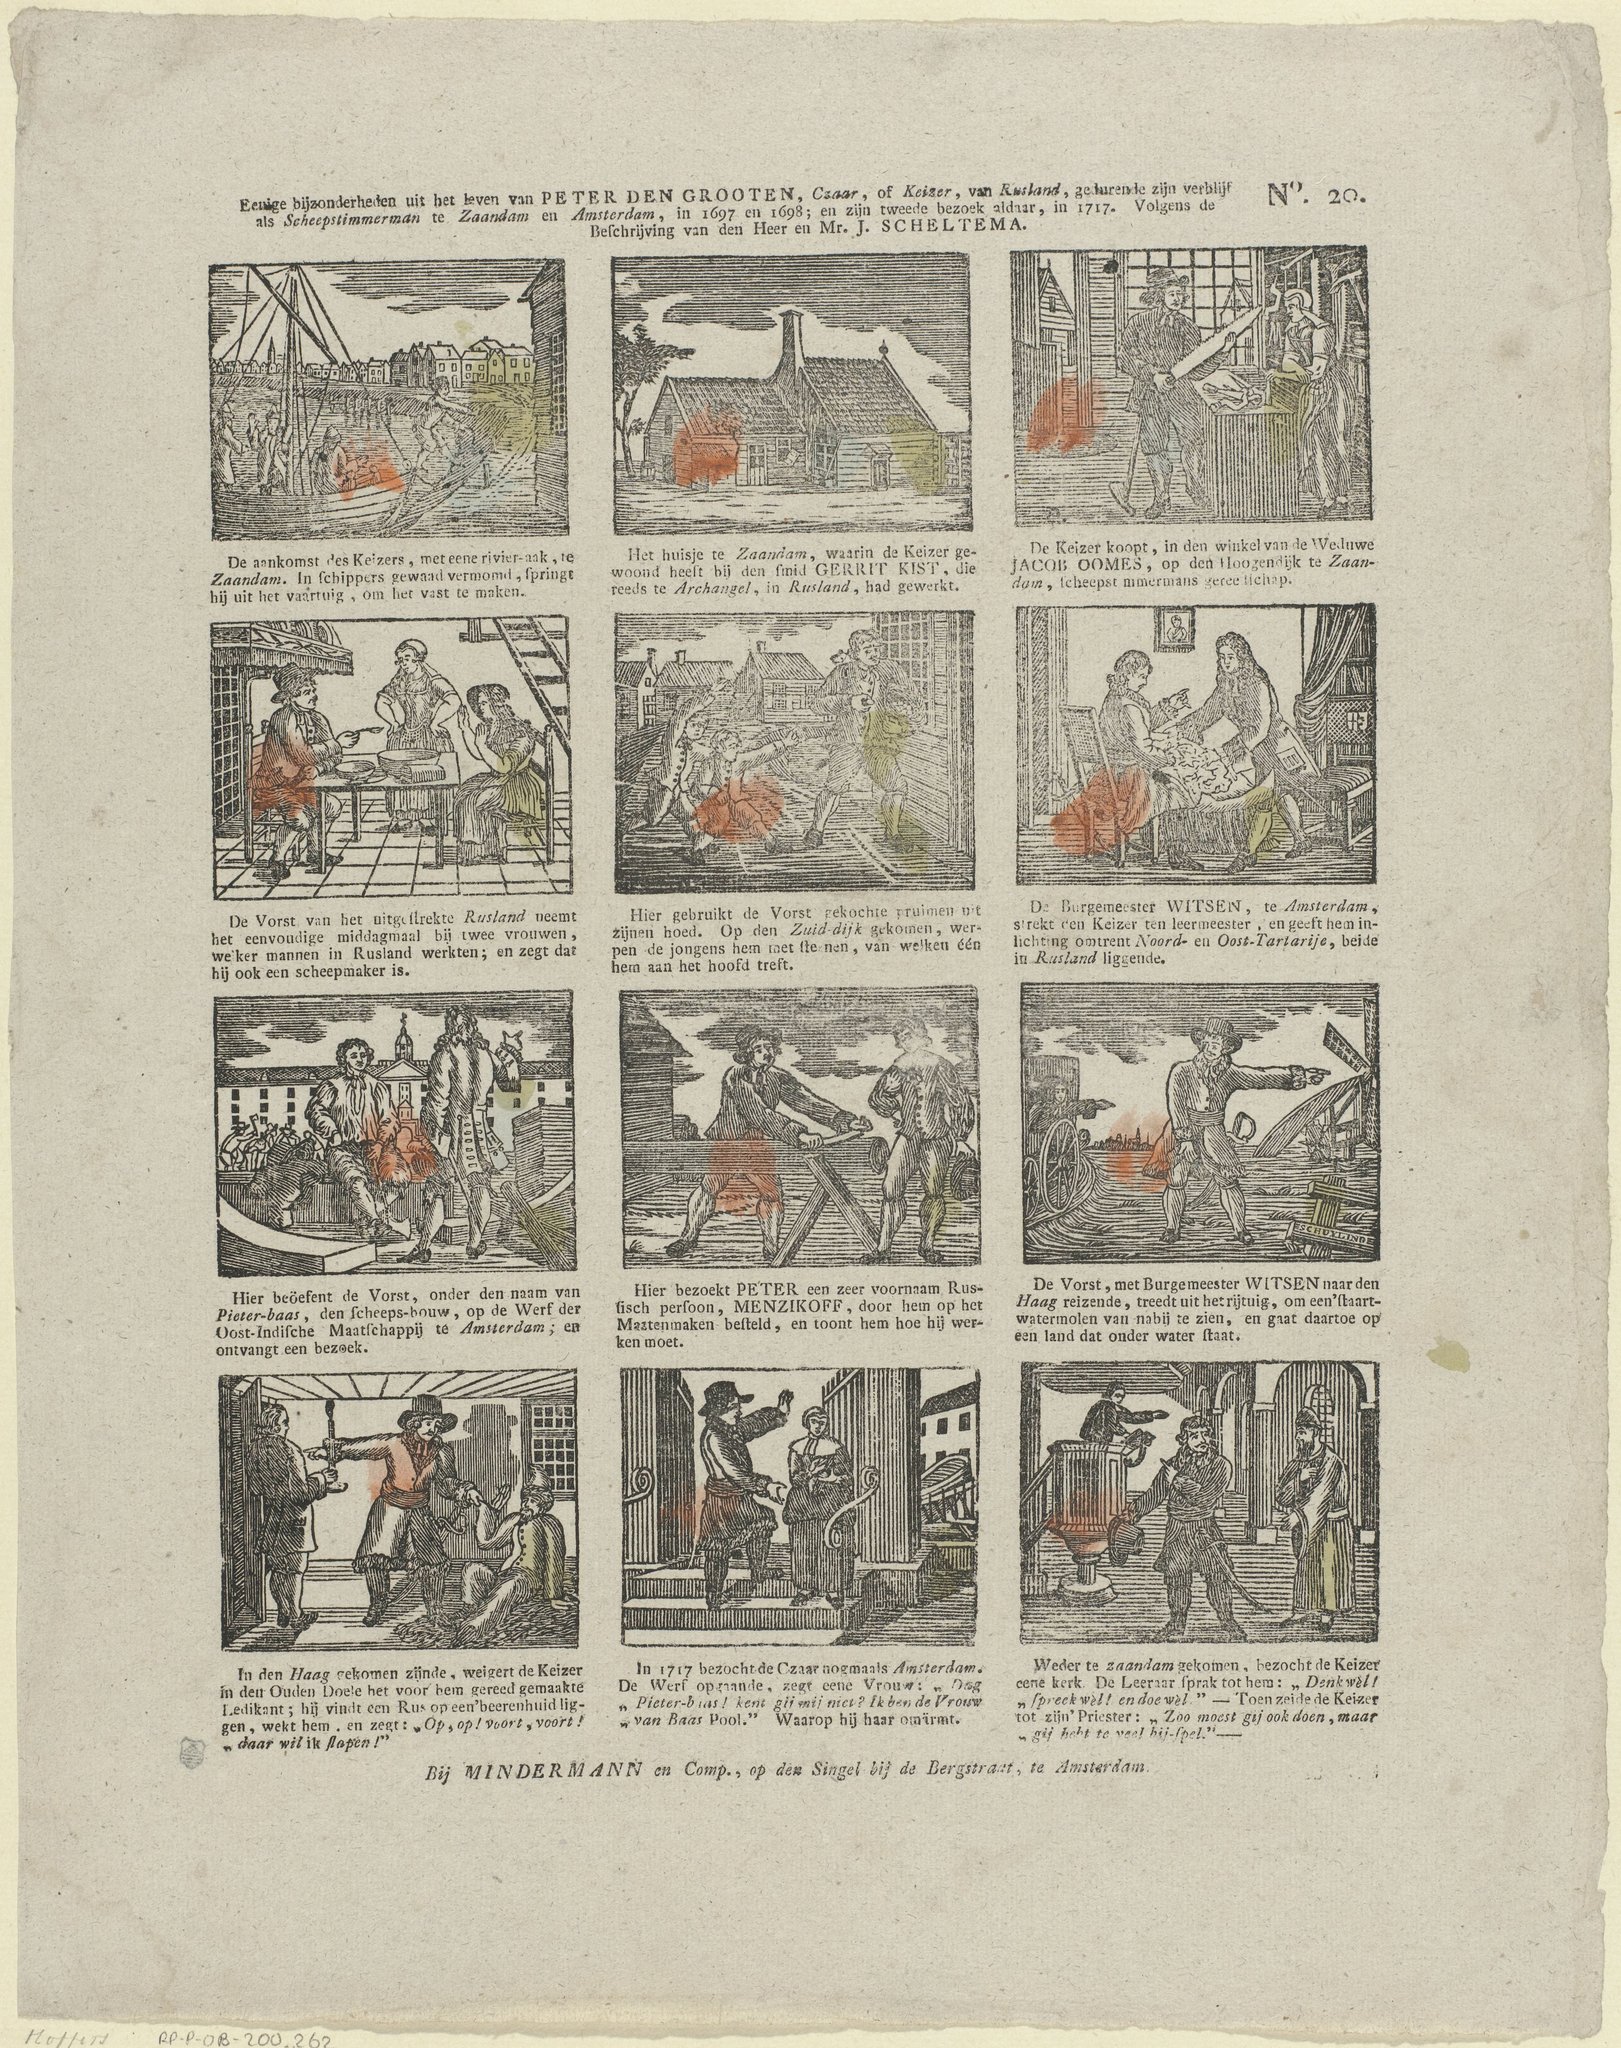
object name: popular print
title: Eenige bijzonderheden uit het leven van Peter den Grooten, Czaar, of Keizer, van Rusland (...)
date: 1820-1848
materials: paper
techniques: colour, letterpress printing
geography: rotterdam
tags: peter i de grote (tsaar van rusland), emperor, shipyard-workers, amsterdam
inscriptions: collector's mark: Lugt 2228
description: Blad met 12 voorstellingen uit het leven van Peter I de Grote, tsaar van Rusland, gedurende zijn verblijf in Zaandam en Amsterdam. Onder elke afbeelding een onderschrift. Genummerd rechtsboven: No. 20.